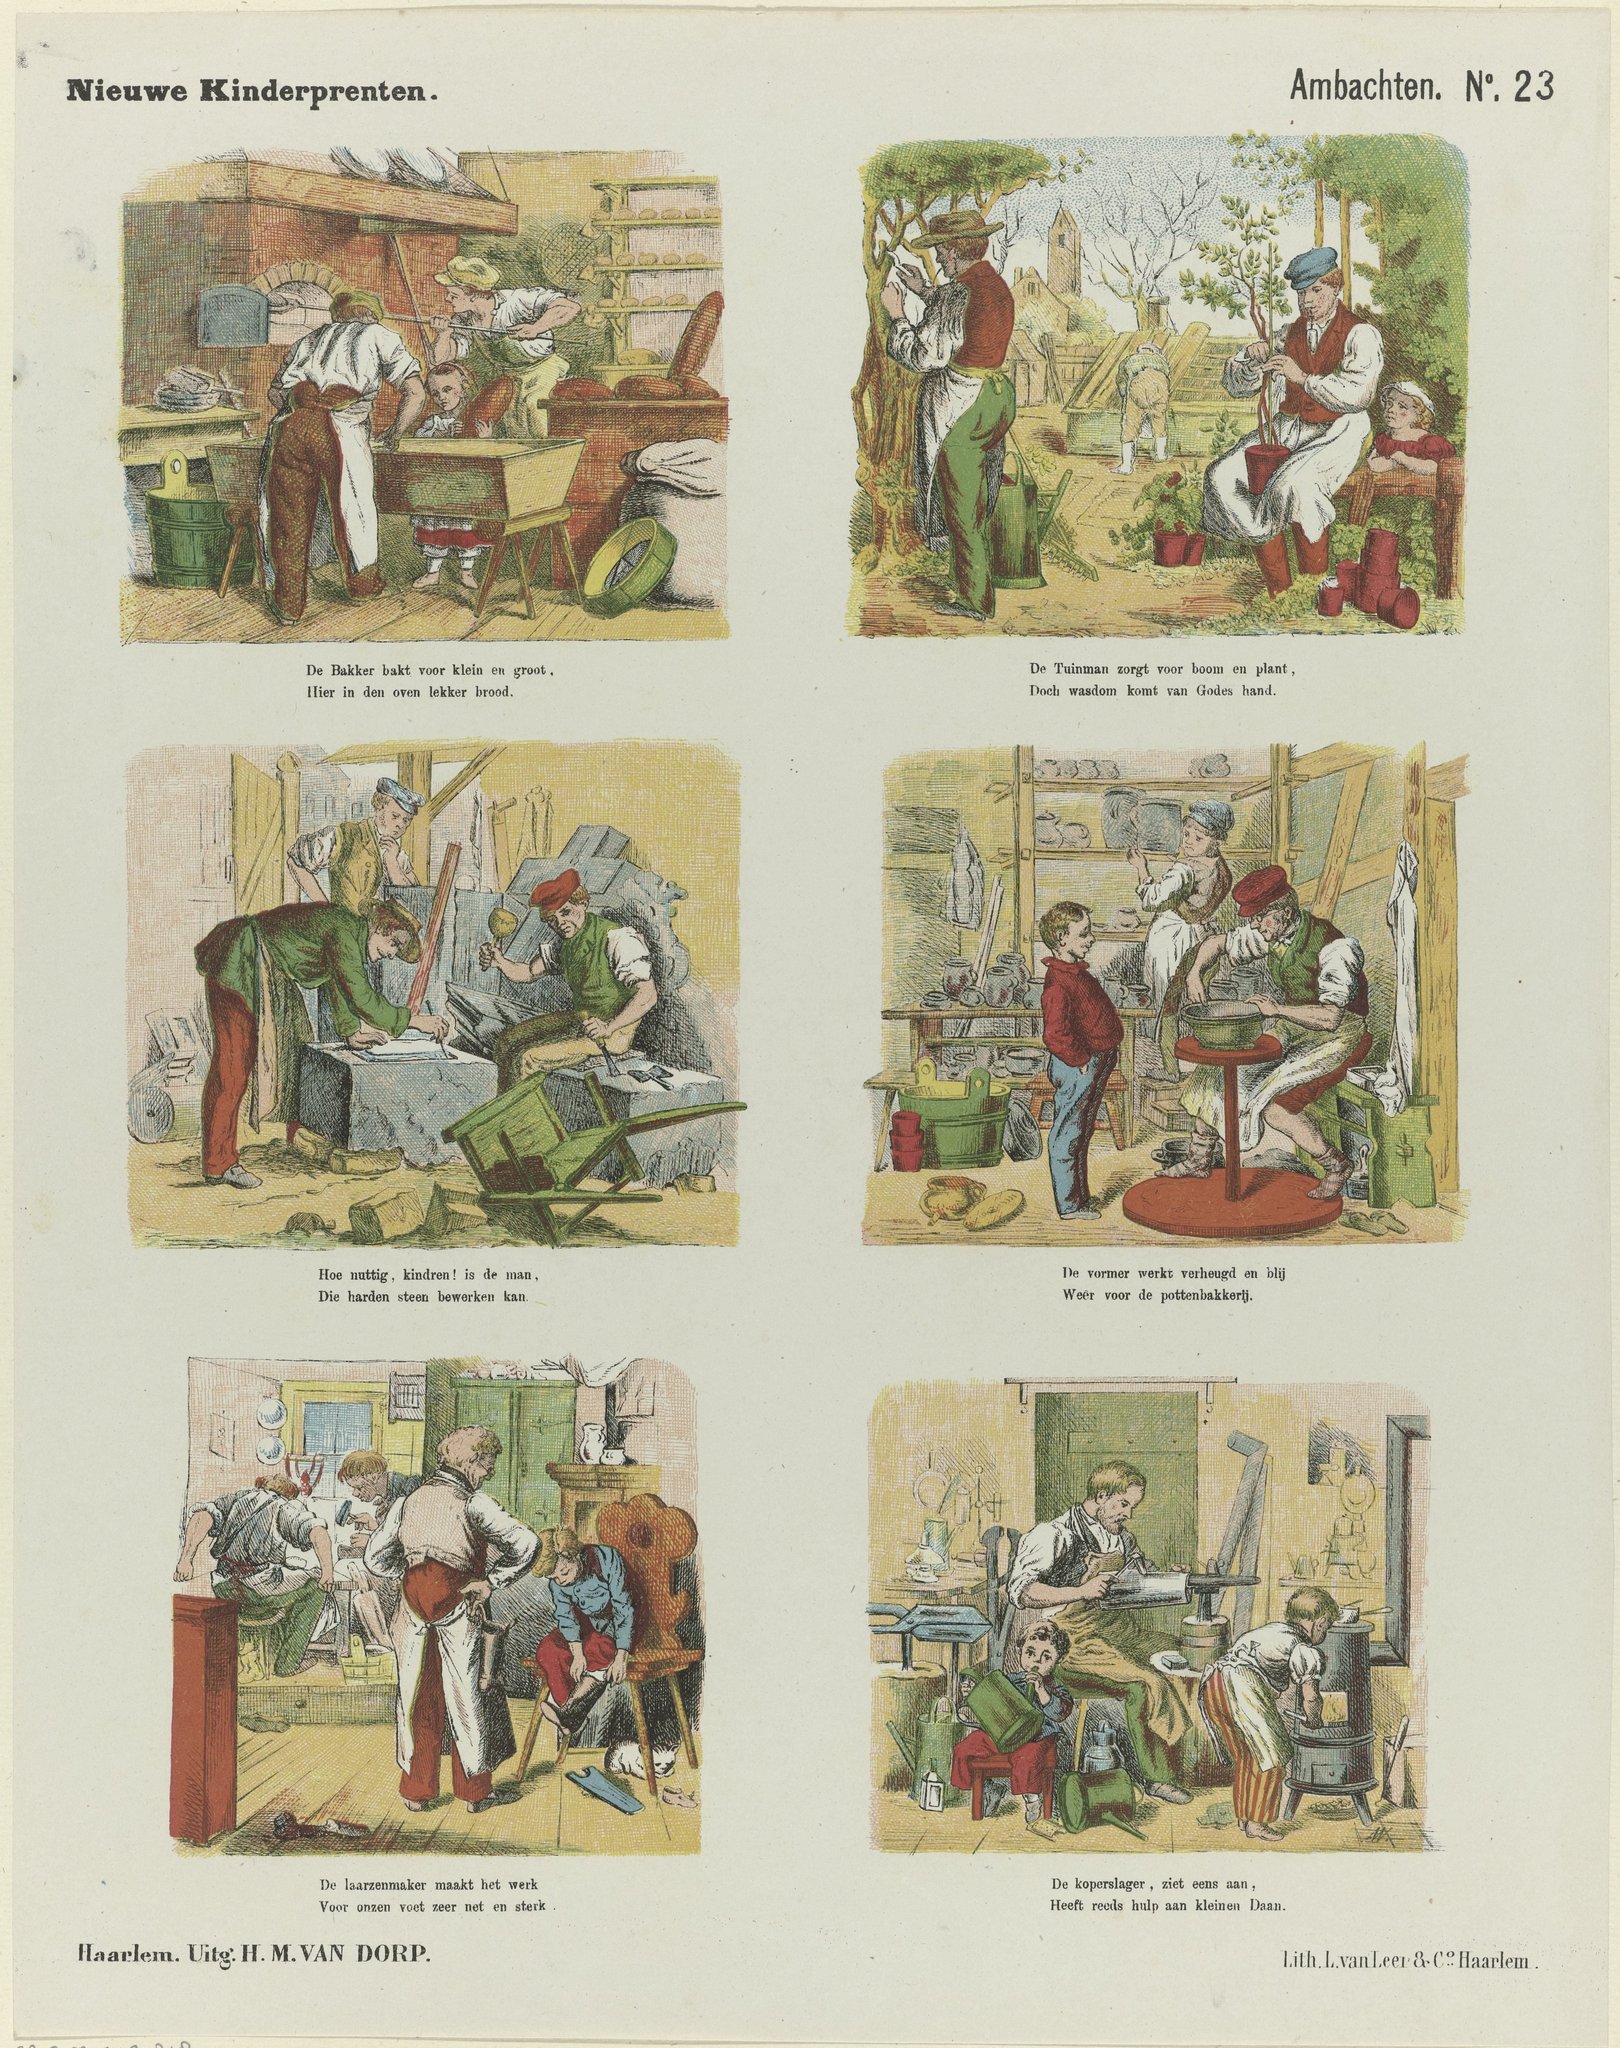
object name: print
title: Nieuwe kinderprenten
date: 1872-1883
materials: paper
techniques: lithograph, letterpress printing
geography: haarlem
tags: craft-production, skilled handiwork, baker, crafts and industries, potter, ceramist, shoe-maker, cobbler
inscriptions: collector's mark: Lugt 2760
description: Blad met 6 voorstellingen van ambachtslieden en beroepen, zoals bakker, tuinman en pottenbakker. Onder elke afbeelding een tweeregelig vers. Genummerd rechtsboven: No. 23.